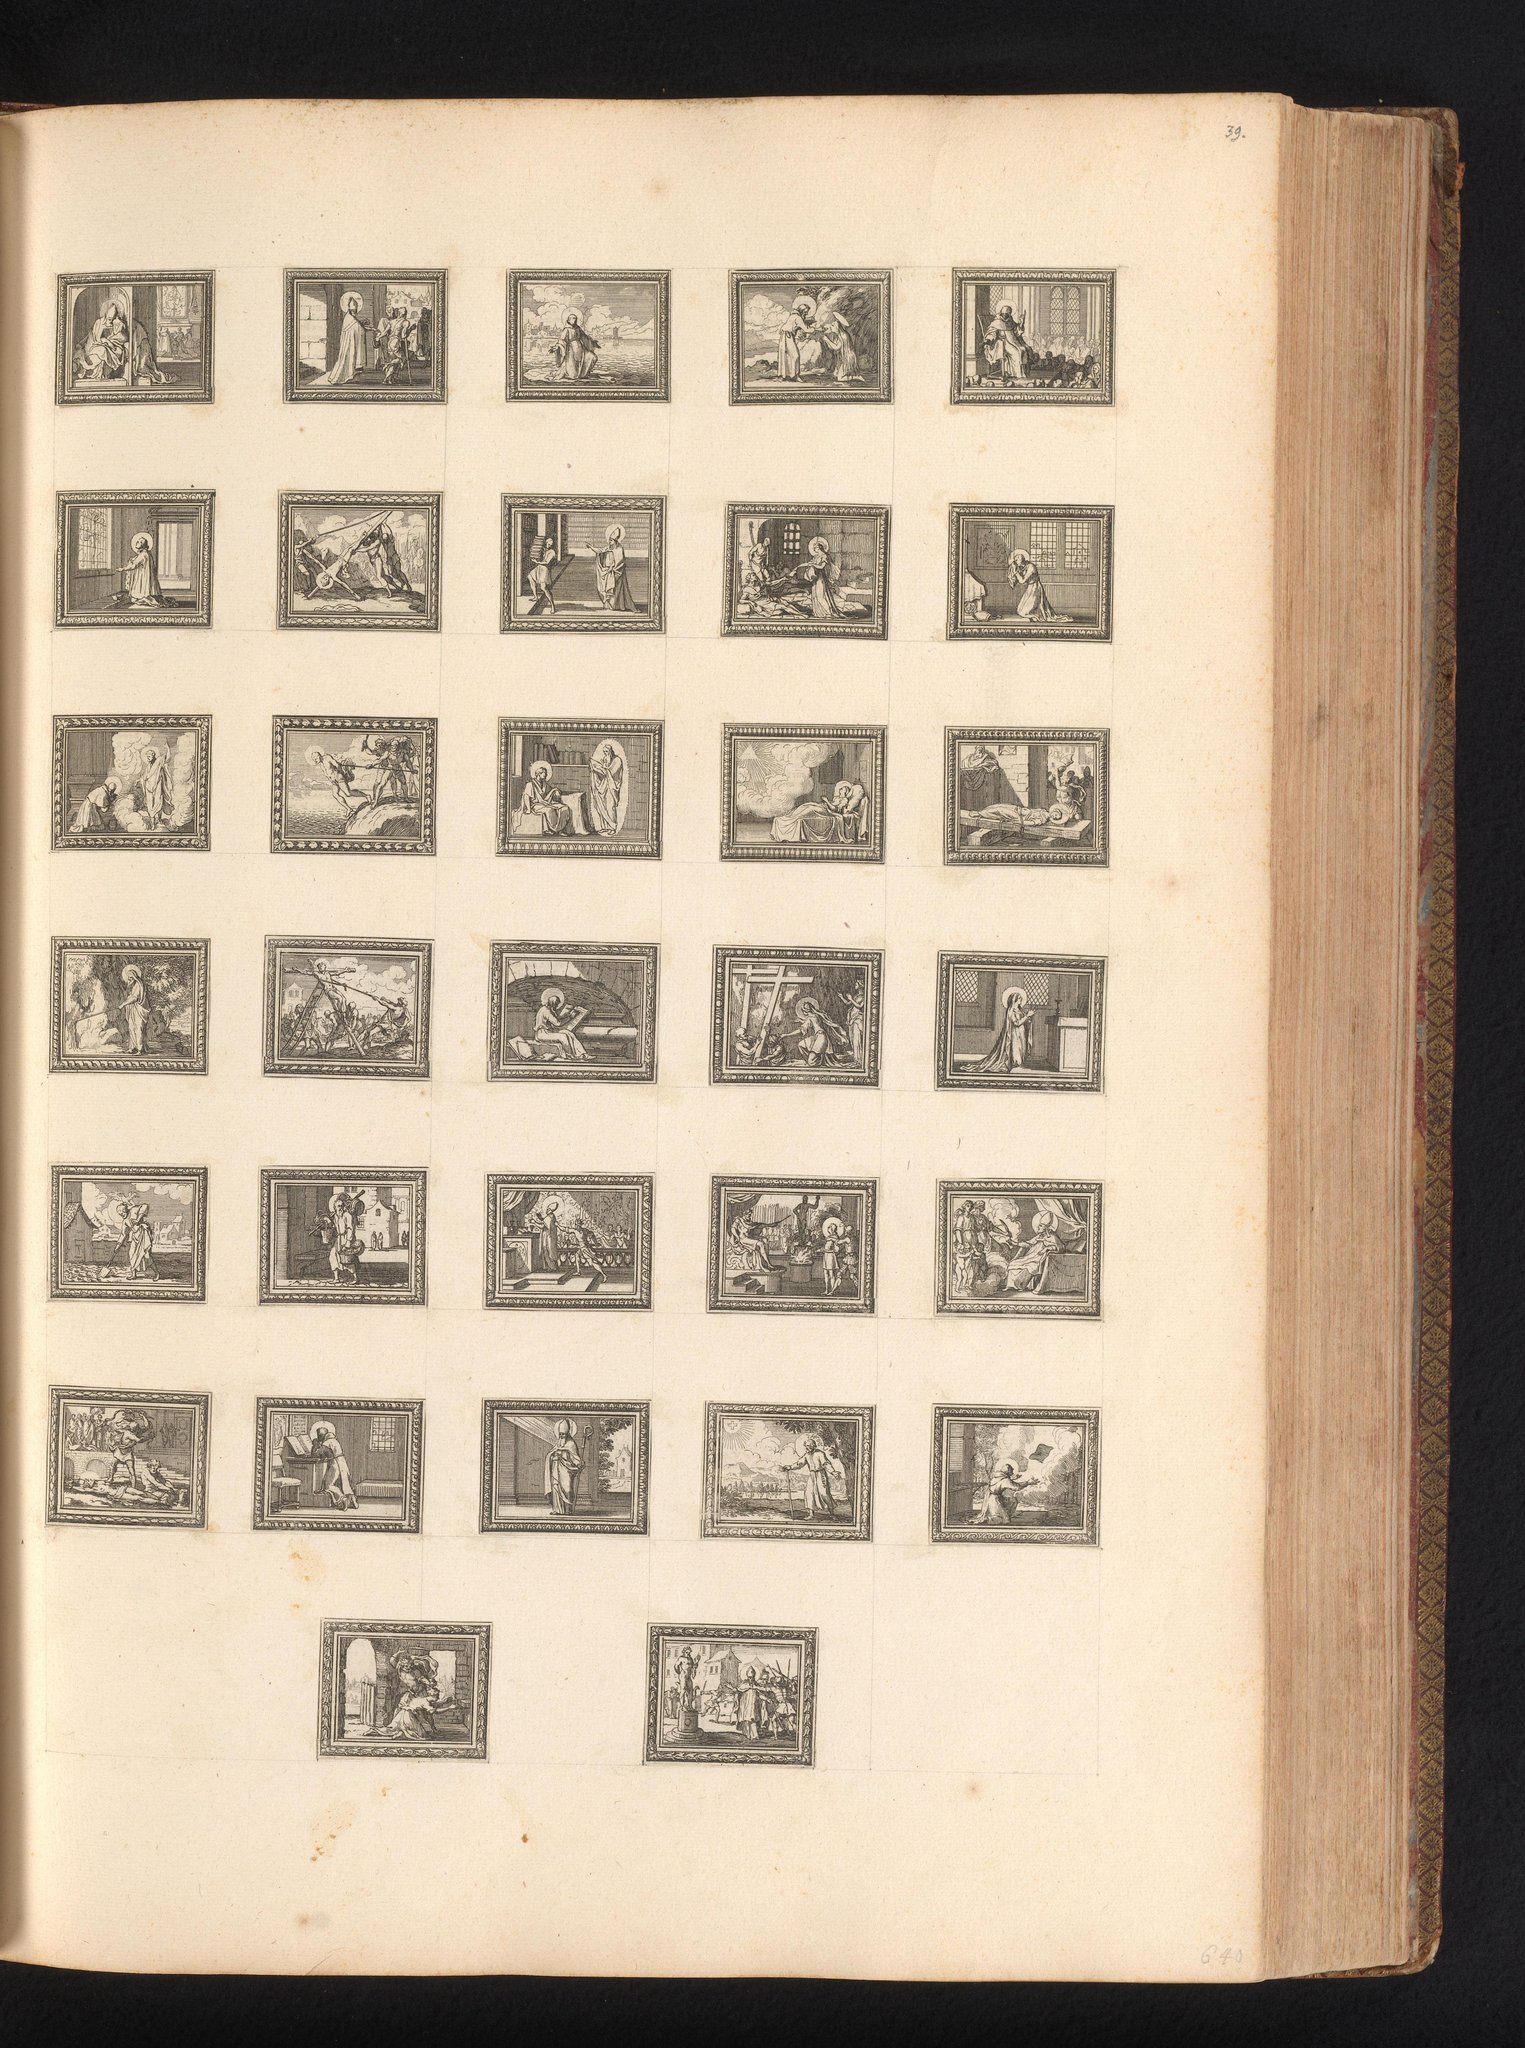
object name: album leaf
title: Heiligen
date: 1647-1706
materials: paper, pencil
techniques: etching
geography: paris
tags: saints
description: Prenten maken deel uit van een serie met voorstellingen van heiligen behorende tot verschillende maanden van het jaar. De serie staat ook wel bekend als 'Les Saints de Gantrel'.